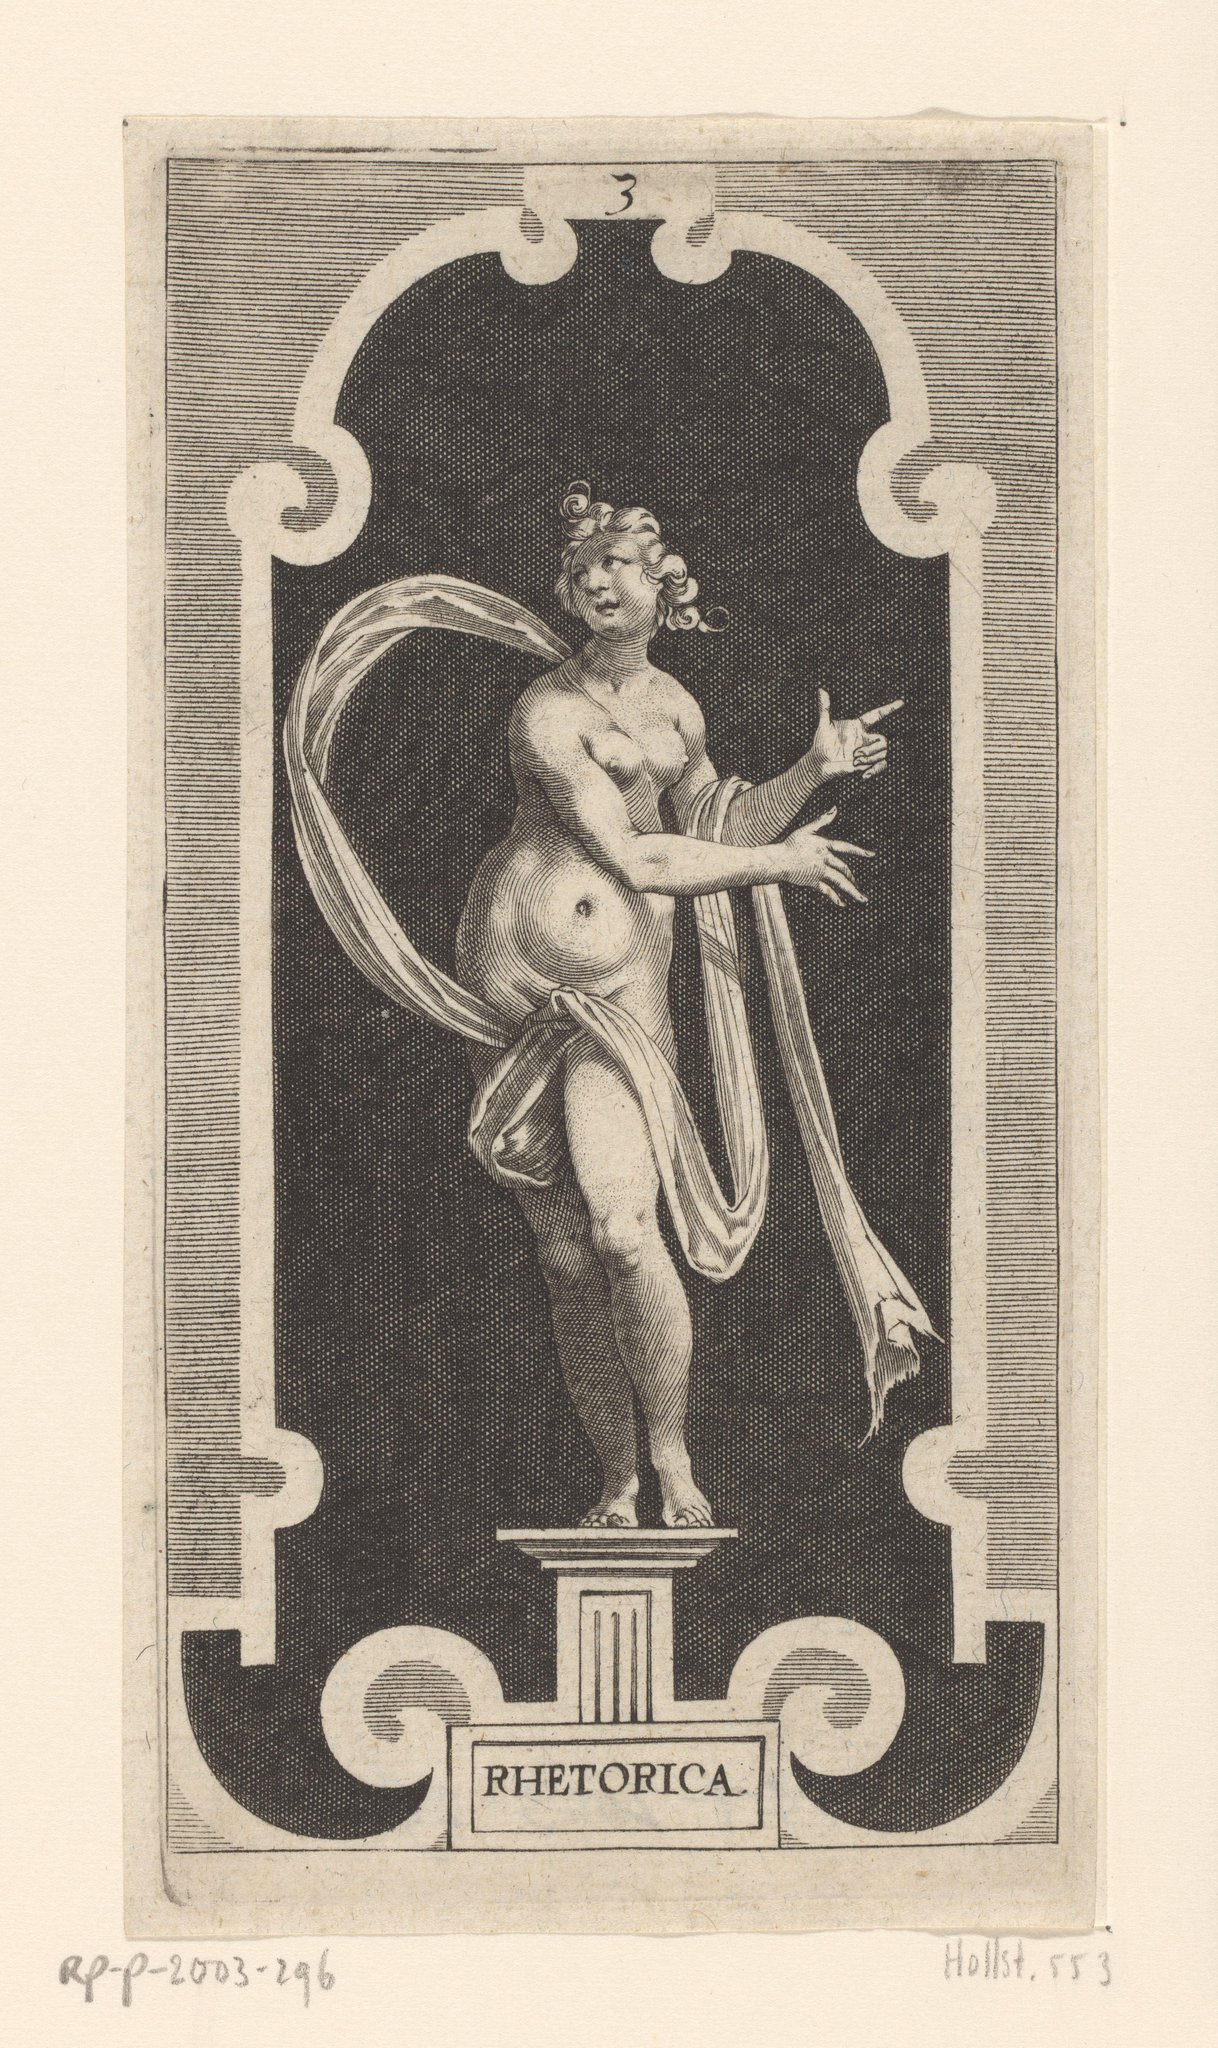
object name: print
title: Zeven Vrij Kunsten in beeld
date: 1640-1708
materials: paper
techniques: engraving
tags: gesture-language, the liberal arts, 'artes liberales', 'rhetorica', 'eloquentia' (~ trivium); 'rettorica' (ripa)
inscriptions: collector's mark: Lugt 2228, collector's mark: Lugt 2760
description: Deze prent hoort bij een serie van zeven prenten met personificaties van Zeven Vrij Kunsten.